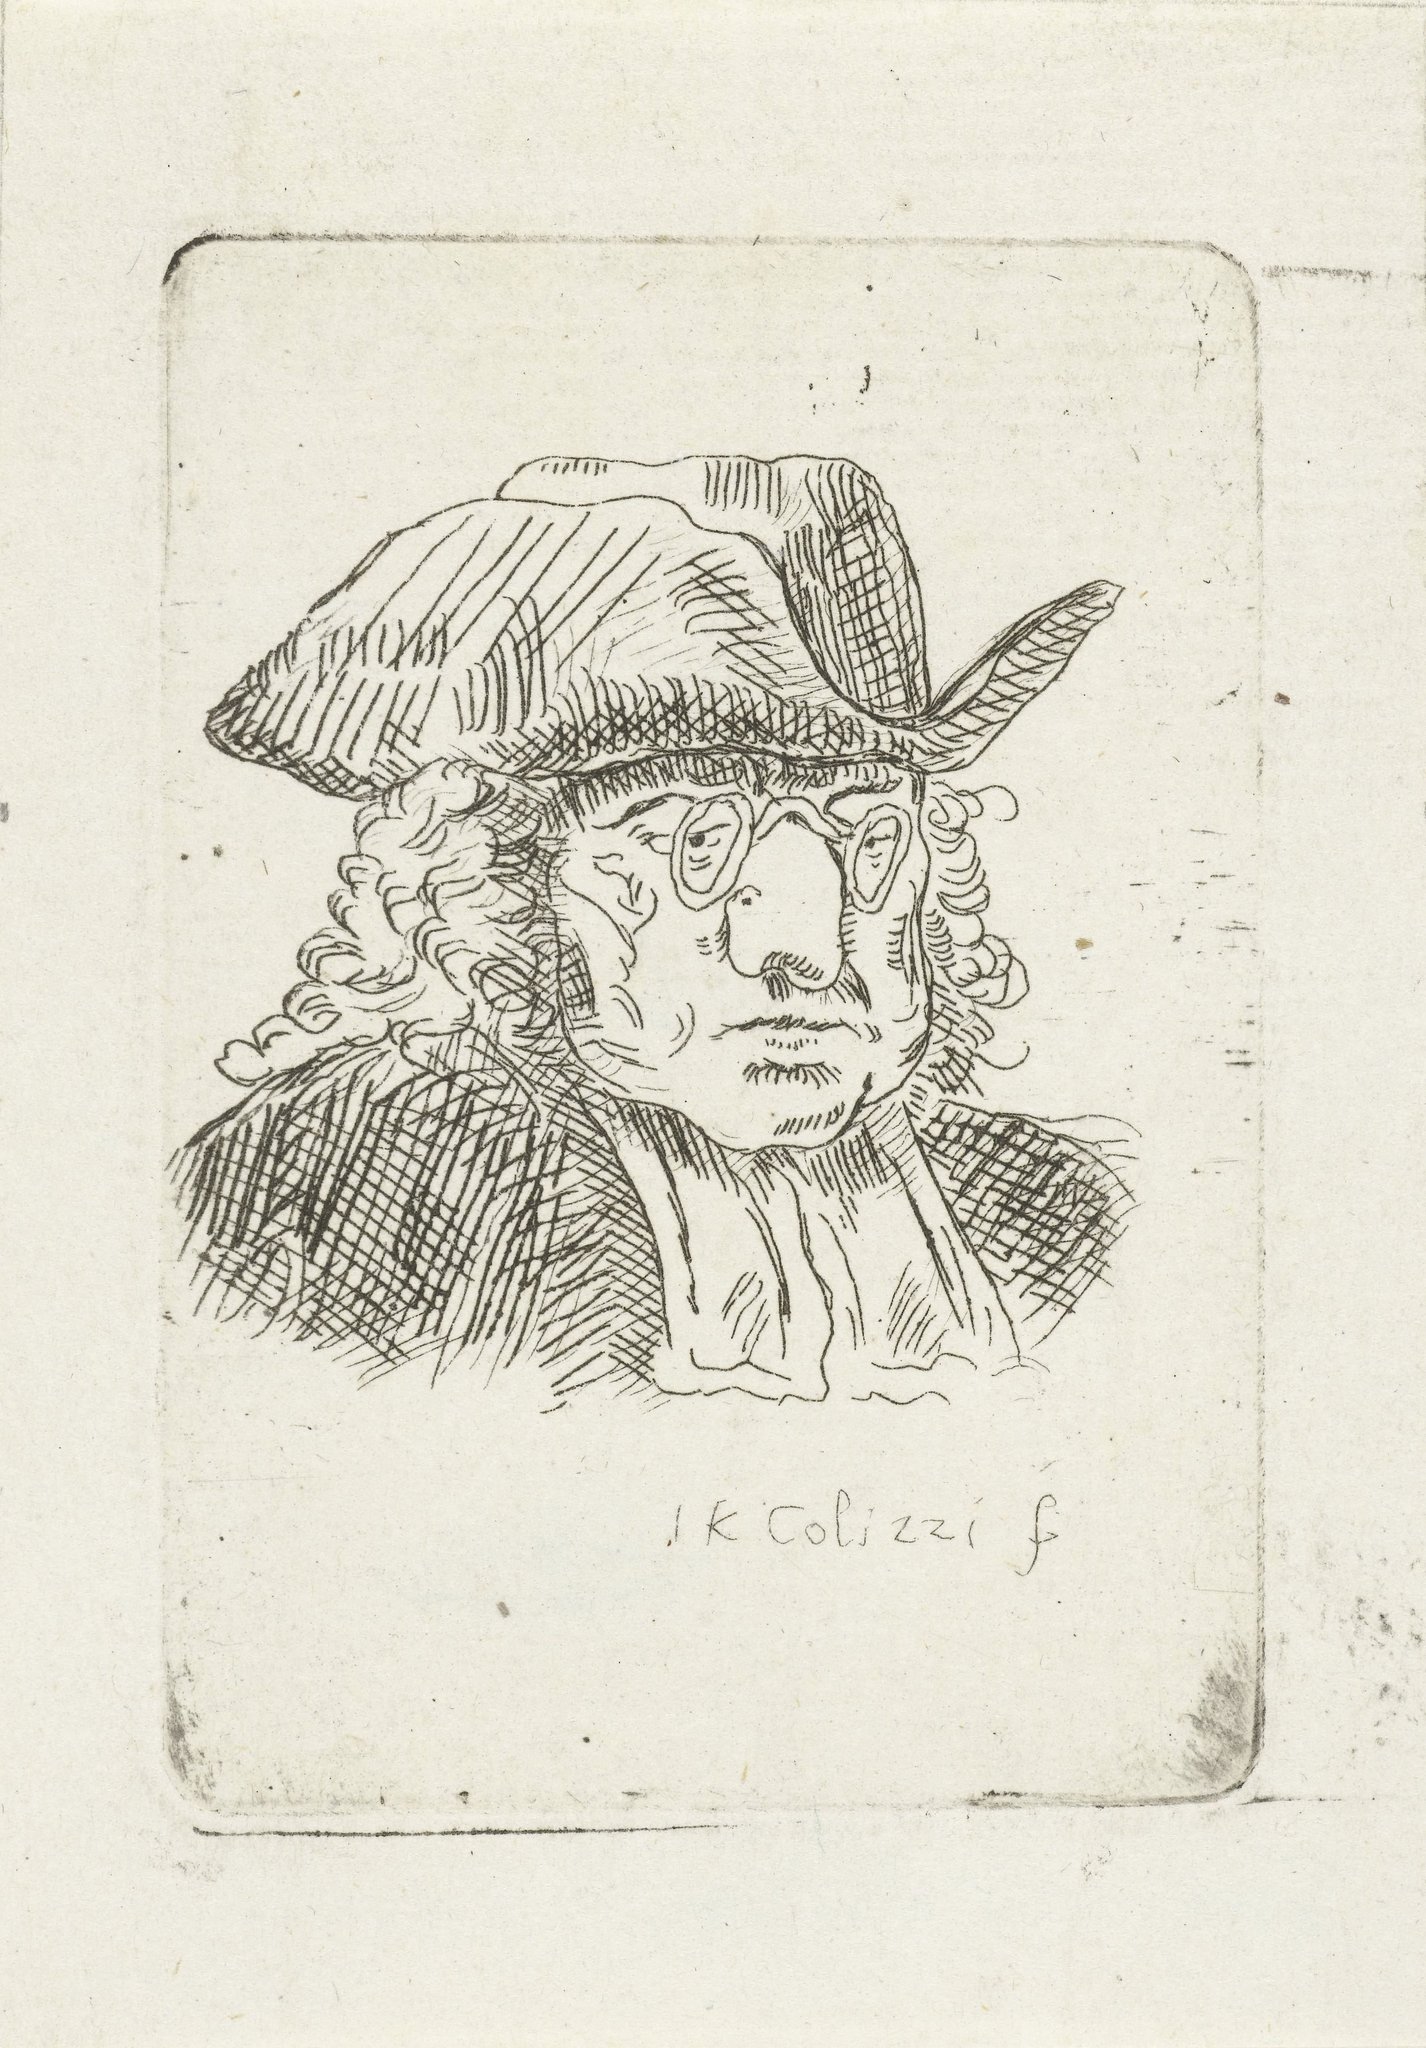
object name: print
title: Portret van Abraham van Wielen met hoed en bril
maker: johan antoni kauclitz colizzi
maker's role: print maker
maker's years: 1742-1808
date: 1774-1808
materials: paper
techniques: etching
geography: netherlands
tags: functionaries and dignitaries ~ protestant churches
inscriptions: collector's mark: Lugt 2760, collector's mark: Lugt 2228